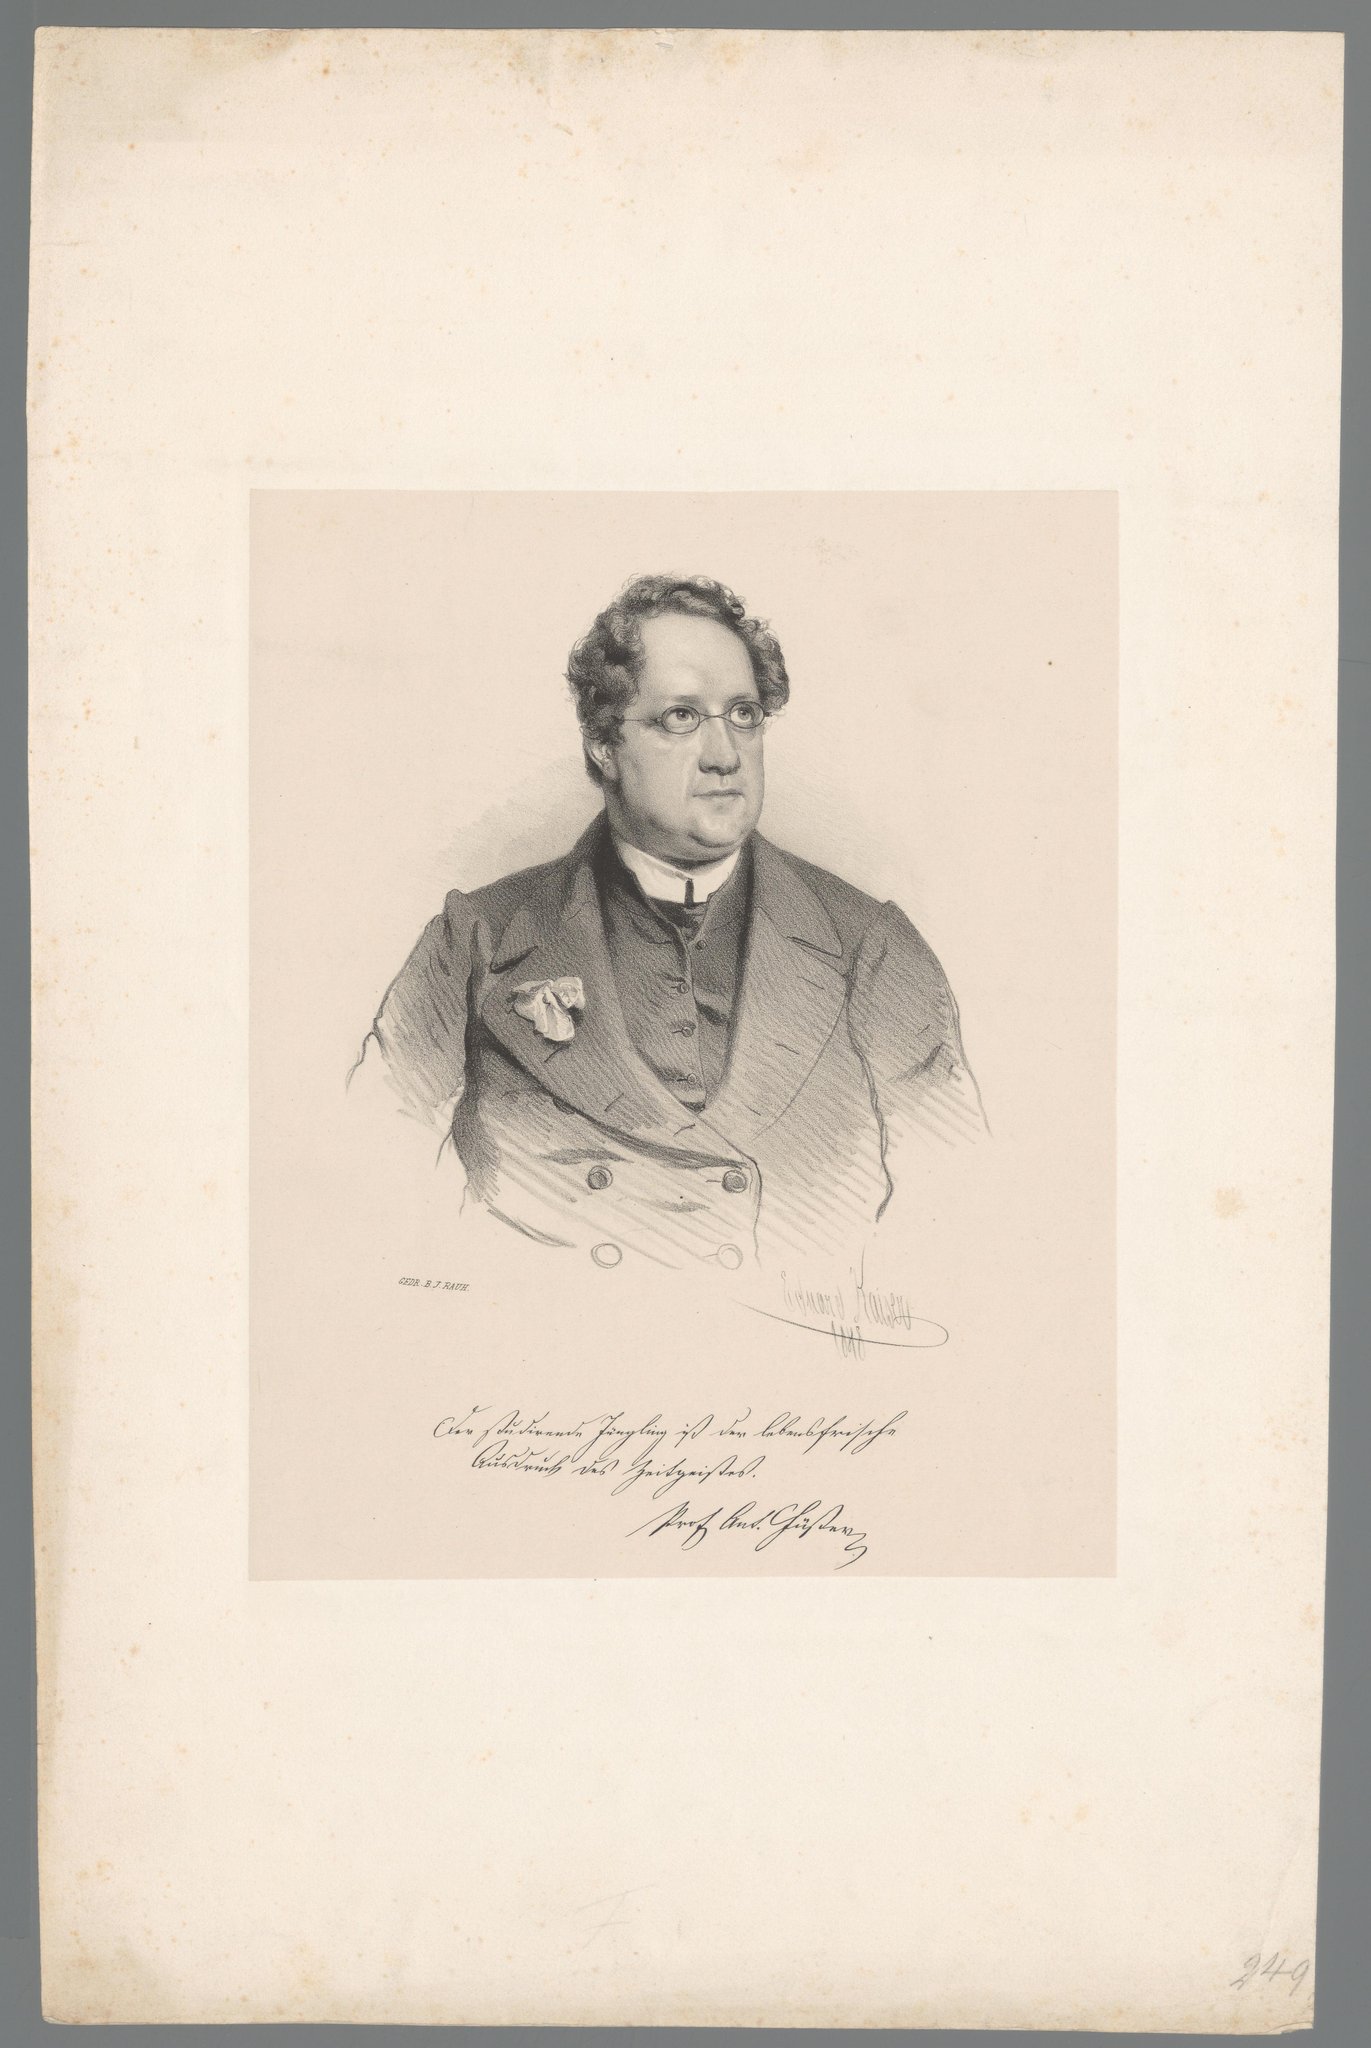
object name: print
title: Portret van Anton Füster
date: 1848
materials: paper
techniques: lithograph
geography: vienna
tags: eyeglasses, spectacles, adult man, historical persons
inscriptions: collector's mark: Lugt 2228